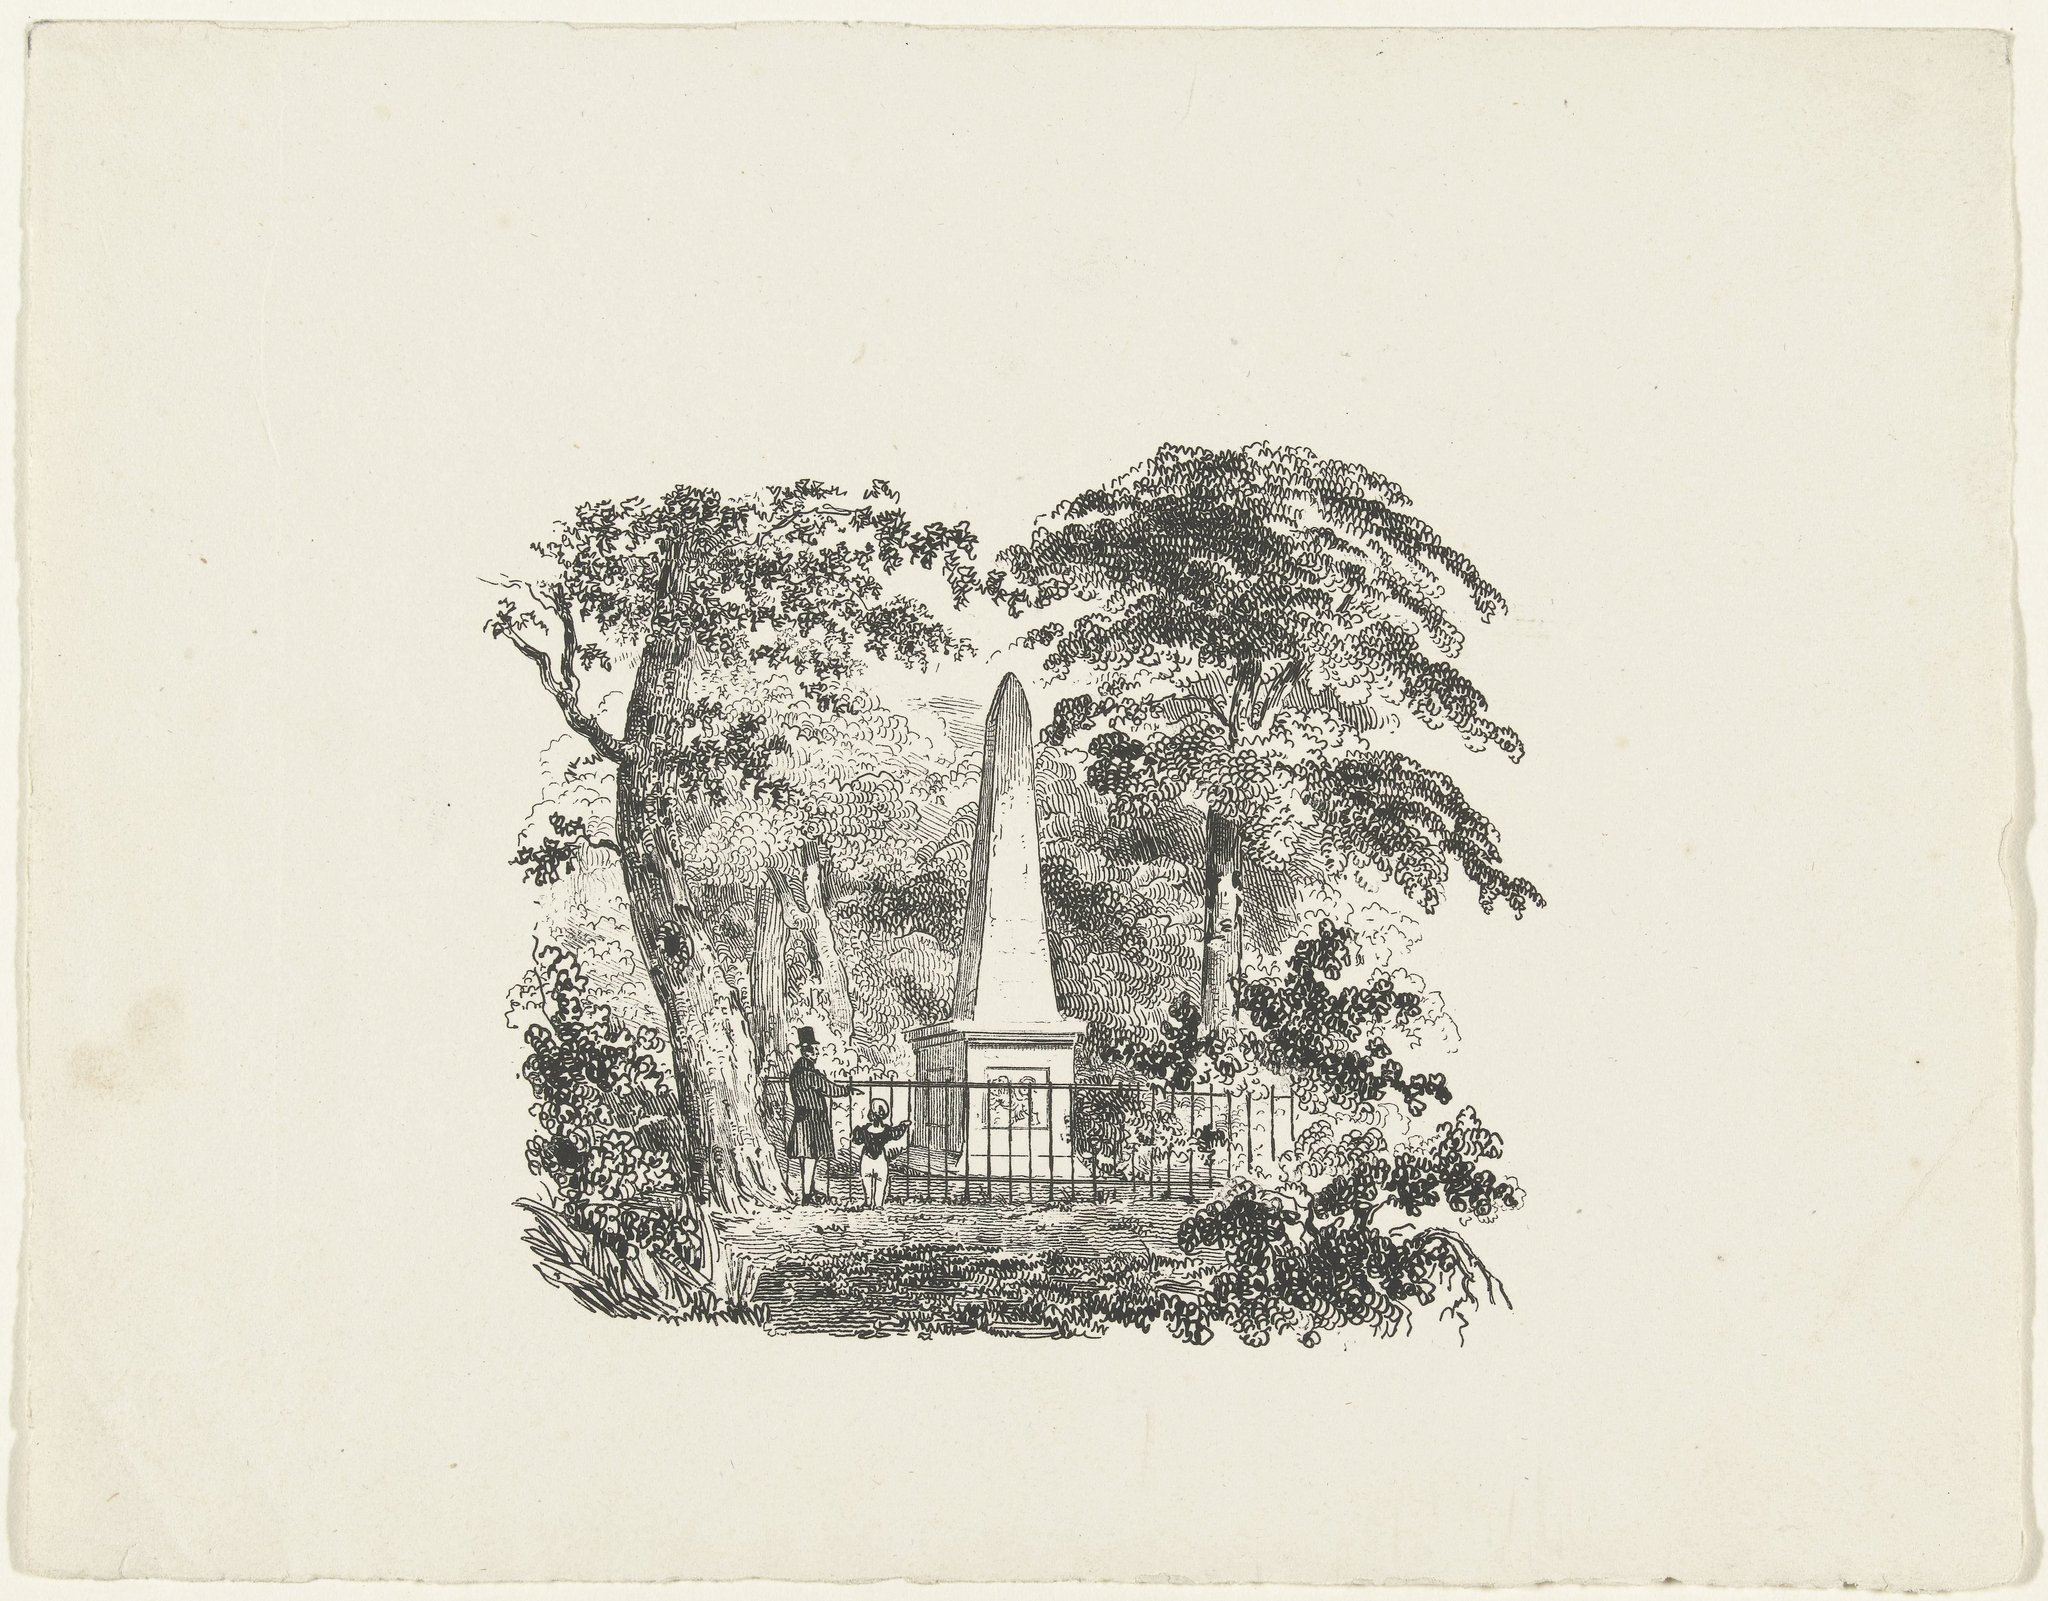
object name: print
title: Gedenkteken ter herinnering aan de gevechten bij het Manpad in 1304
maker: Anonymous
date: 1835-1838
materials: paper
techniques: engraving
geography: netherlands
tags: amsterdam, monument, statue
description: Gedenkteken opgericht in 1817 ter herinnering aan de gevechten bij het Manpad te Heemstede: de overwinning op en de verdrijving van de Vlamingen op 26 april 1304 en een episode uit het Beleg van Haarlem op 8 juli 1573. Monument waaromheen een hek staat, een man en een jongen ernaast.